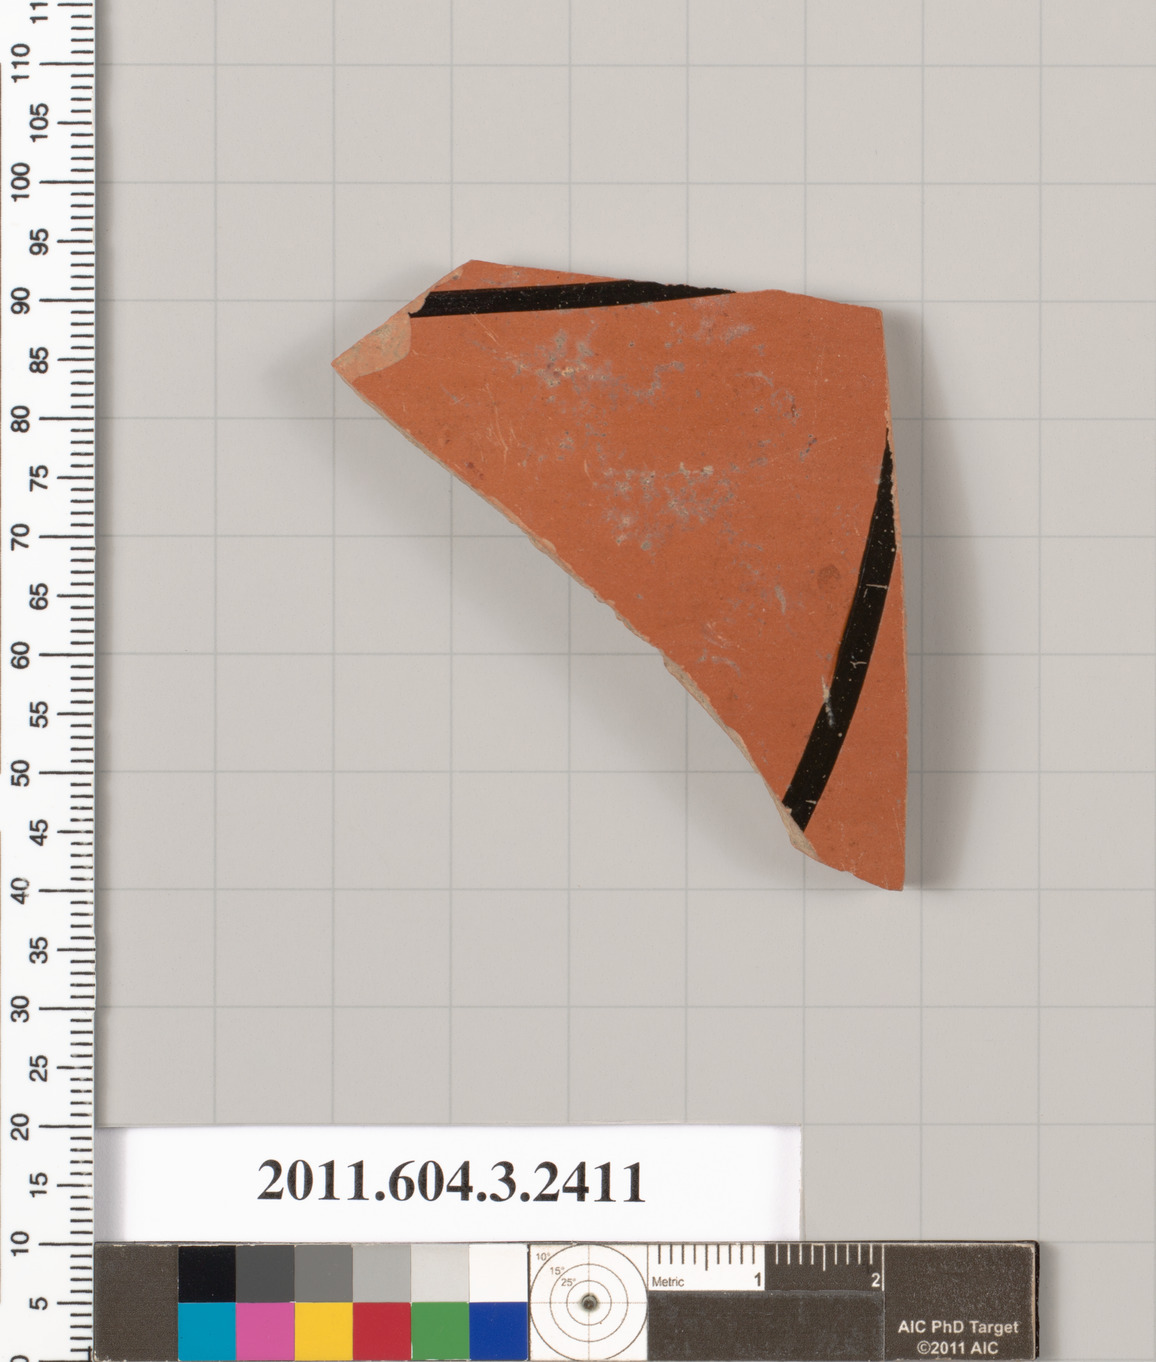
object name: kylix fragment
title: Terracotta fragment of a kylix: eye-cup (drinking cup)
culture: greek, attic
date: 530-510 BCE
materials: terracotta